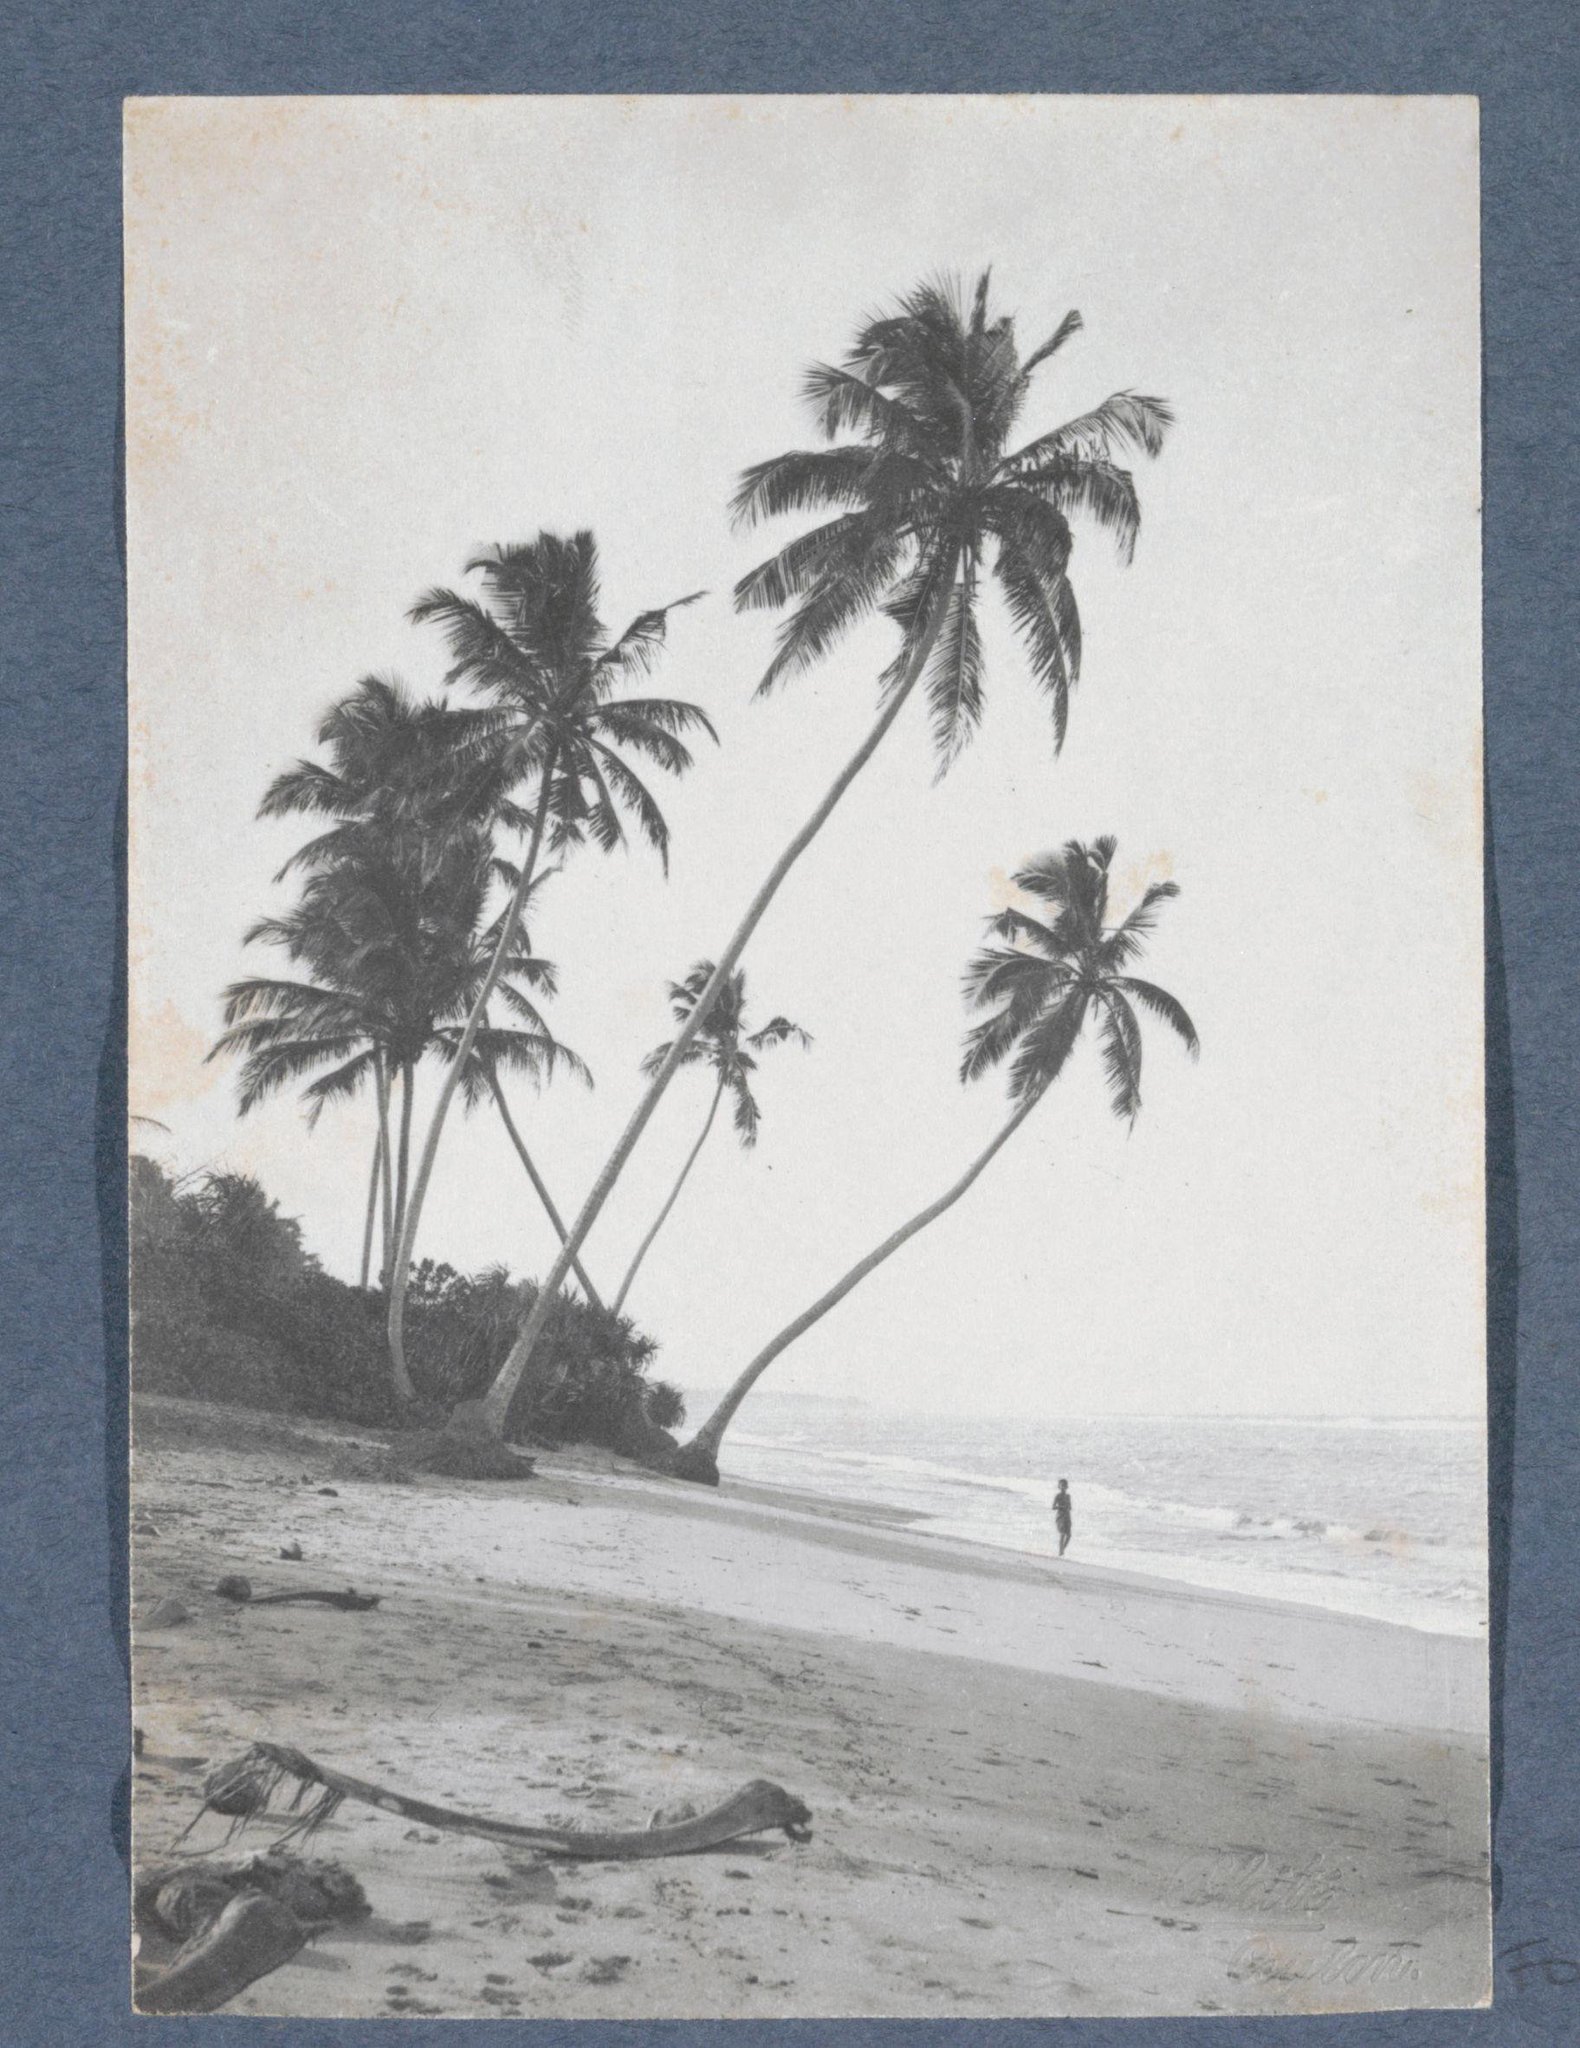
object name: photograph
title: Olifant met kind en drijver op Ceylon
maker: Anonymous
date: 1900-1920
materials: paper, photographic support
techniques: platinum process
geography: sri lanka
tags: riding on animal other than horse, ass, or mule, trunked animals: elephant, sri lanka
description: Onderdeel van reisalbum met foto's van bedrijvigheid en bezienswaardigheden op Sumatra en Java en van de reis naar en van Nederlands-Indië.